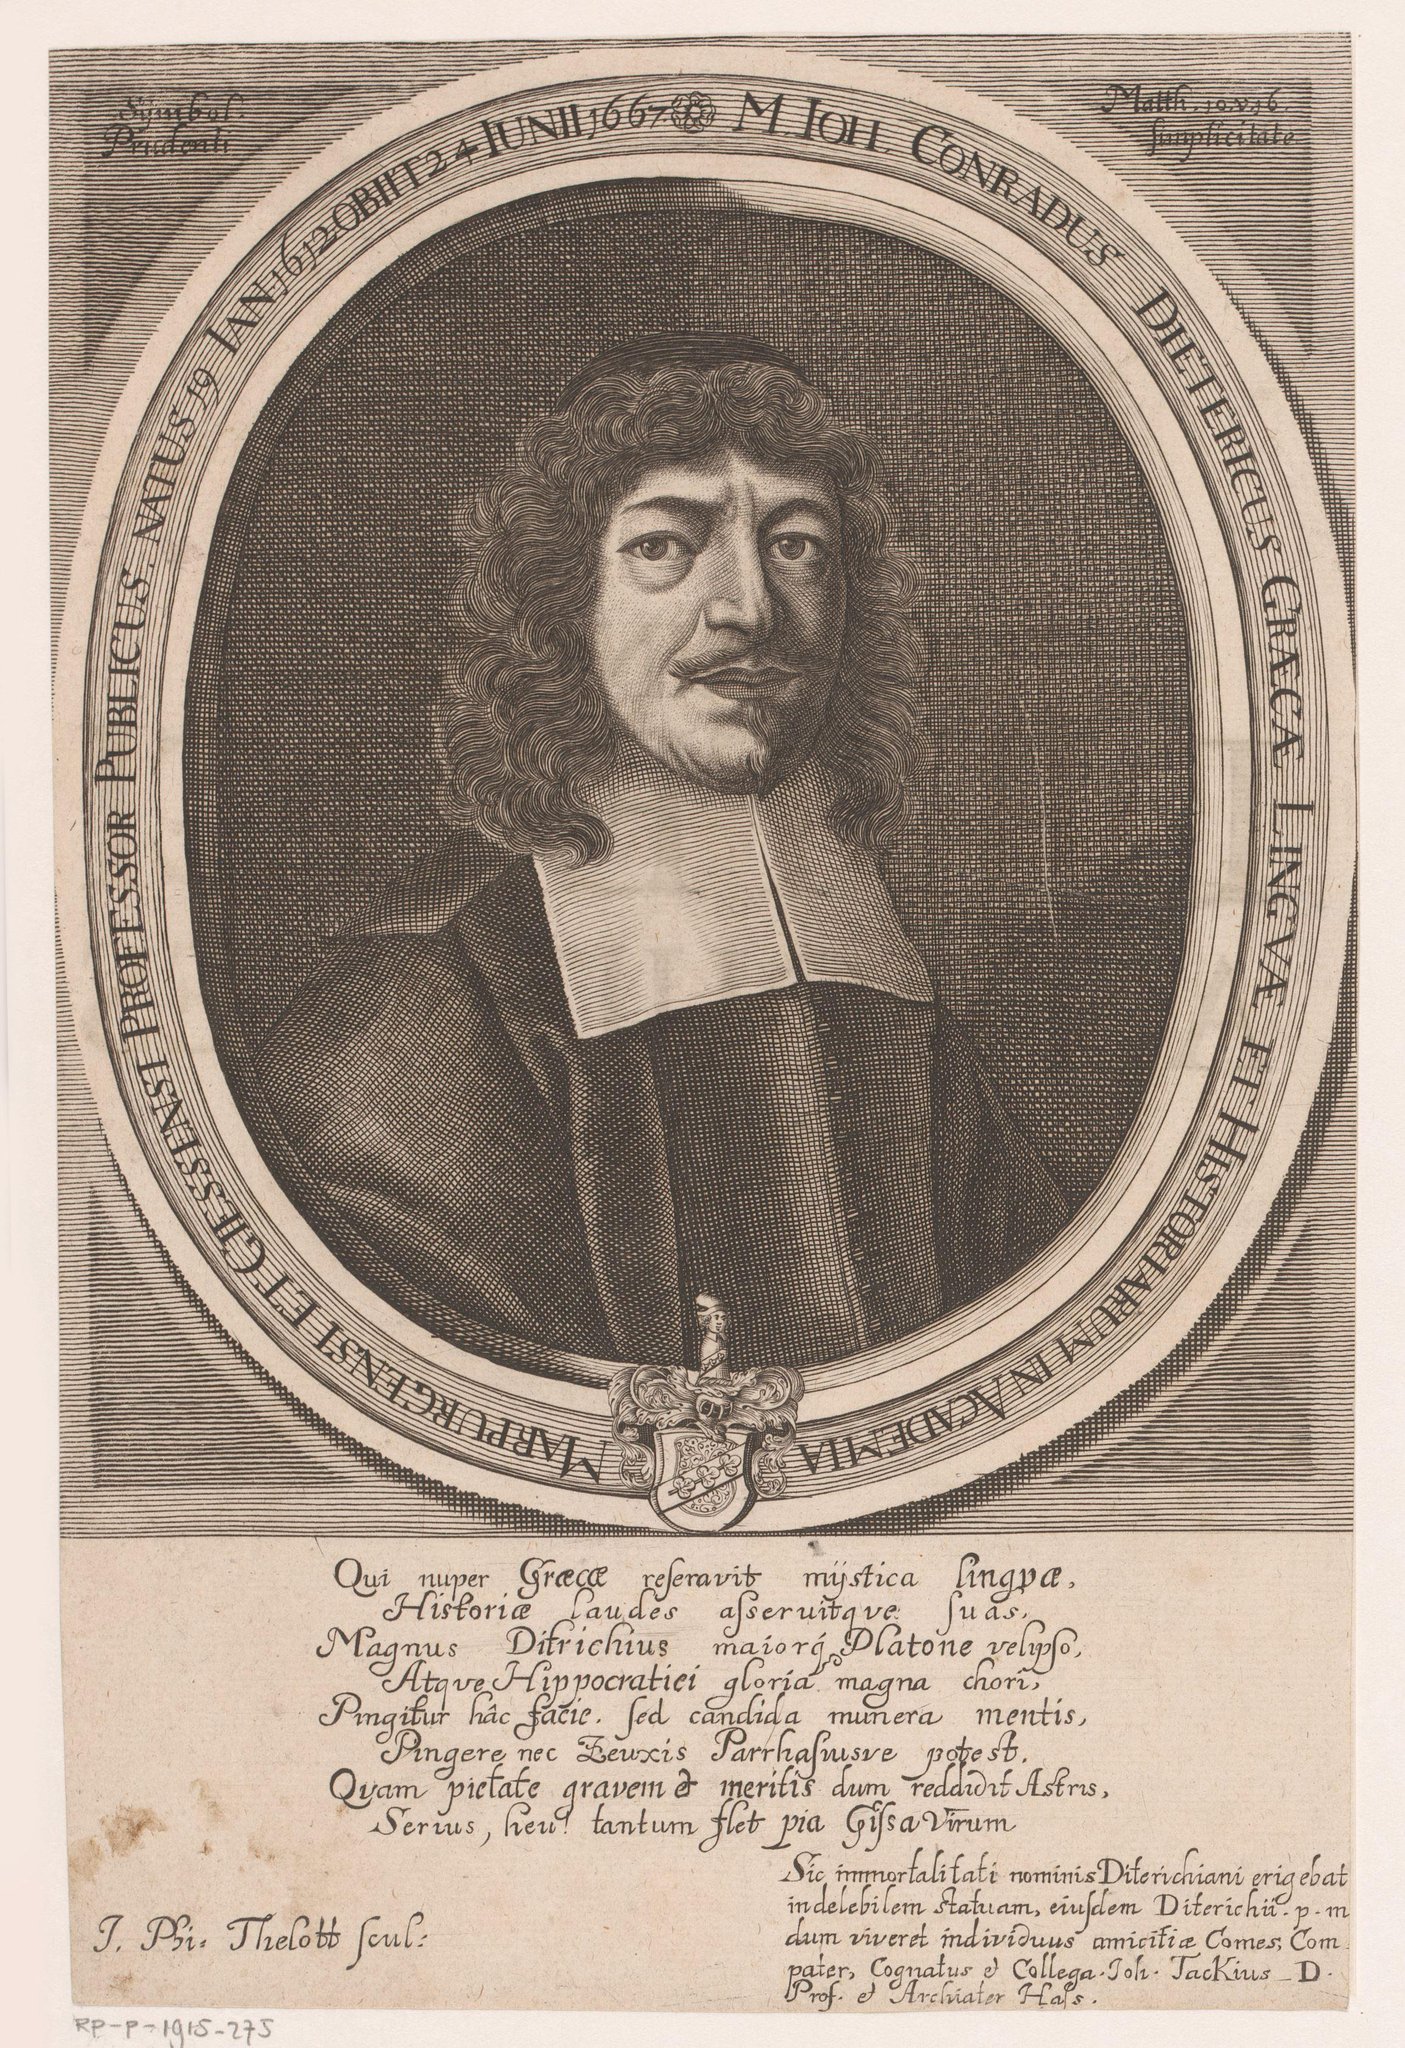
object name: book illustration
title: Portret van Johann Konrad Dieterich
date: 1671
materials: paper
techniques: engraving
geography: giessen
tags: historical persons, armorial bearing, heraldry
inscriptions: collector's mark: Lugt 2228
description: Prent afkomstig uit: Dieterich, Johann Konrad. Antiquitates biblicae. Giessen: Jakob Gottfried Seyler, 1671.